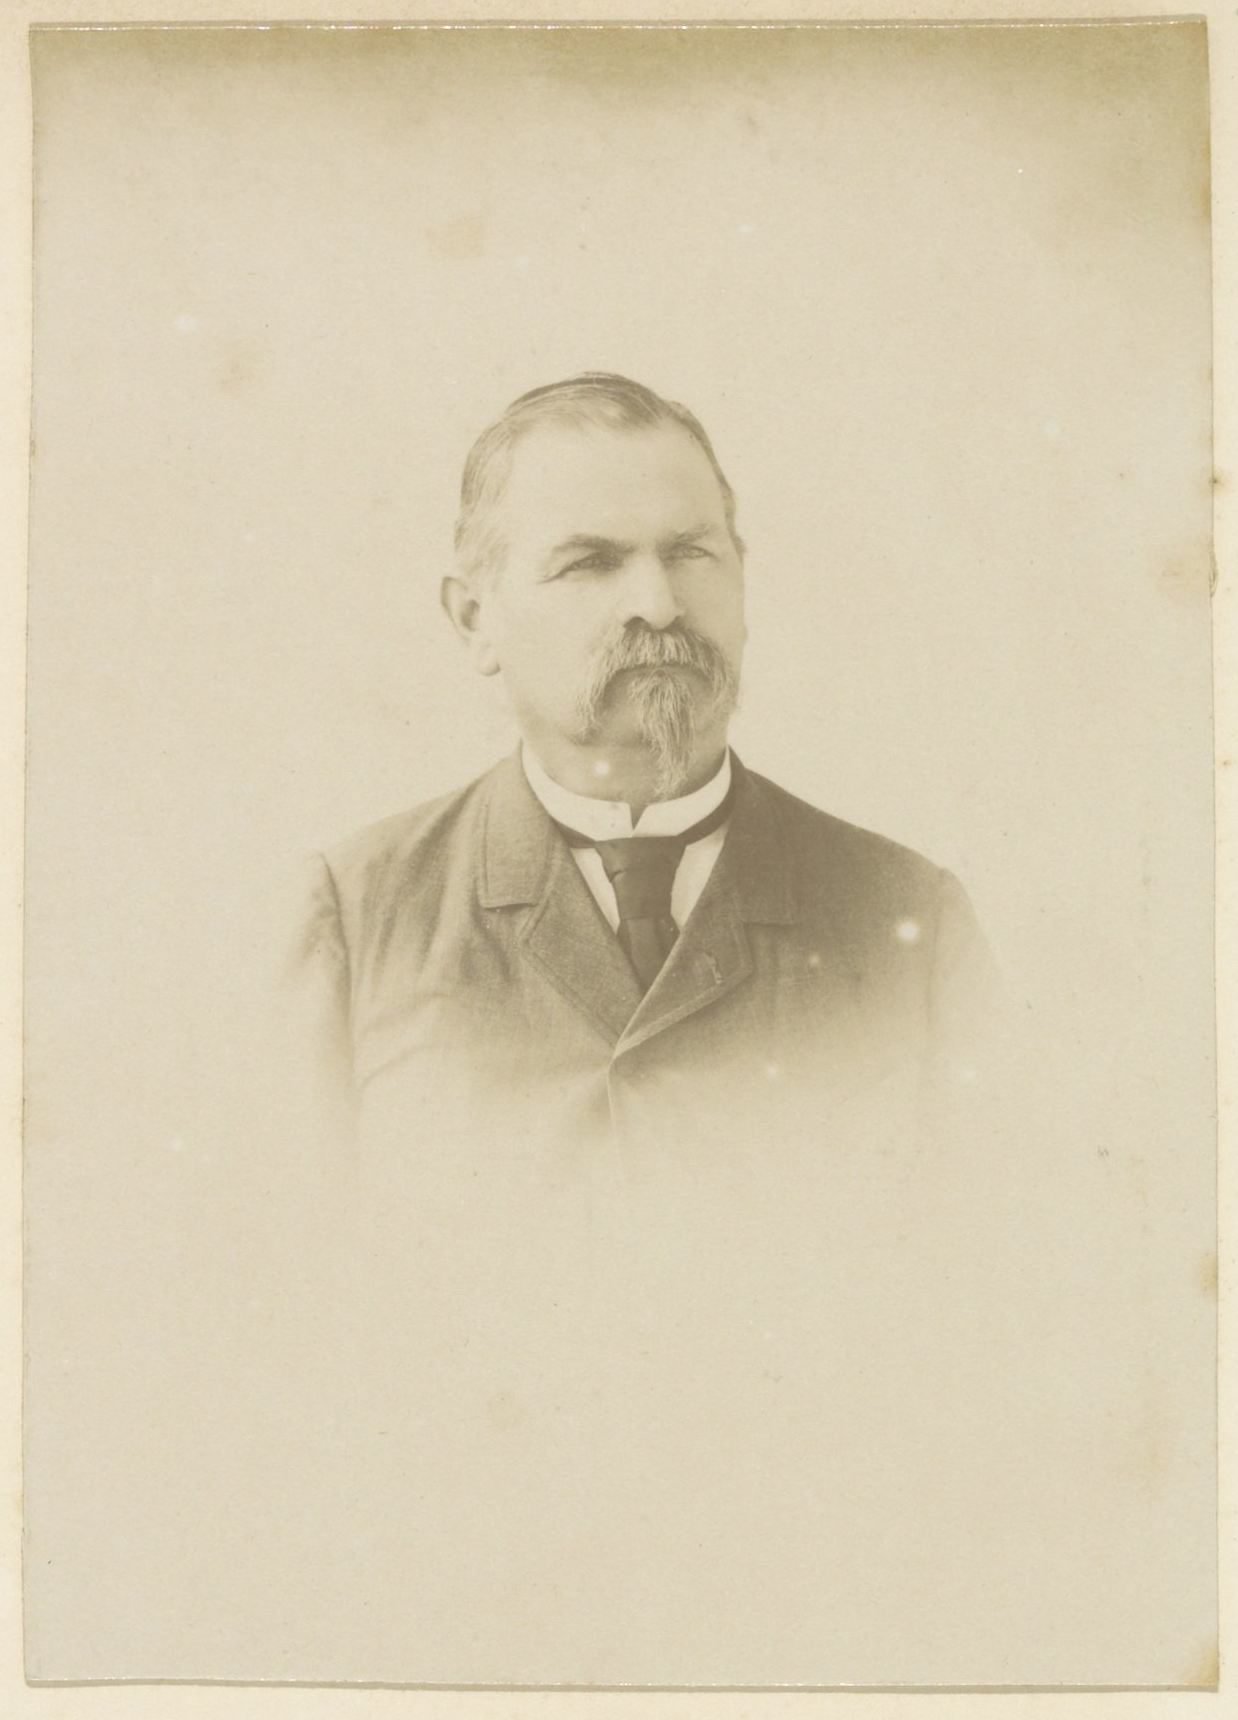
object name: photograph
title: Portret van een Franse man met een sik en een snor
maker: Anonymous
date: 1900-1910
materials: paper, photographic support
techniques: albumen print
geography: france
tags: moustache, adult man, beard, france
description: Onderdeel van Fotoalbum van een Franse amateurfotograaf met opnames van een familie, distilleerderij Delizy & Doistau Fils, het leger en bezienswaardigheden in Frankrijk.